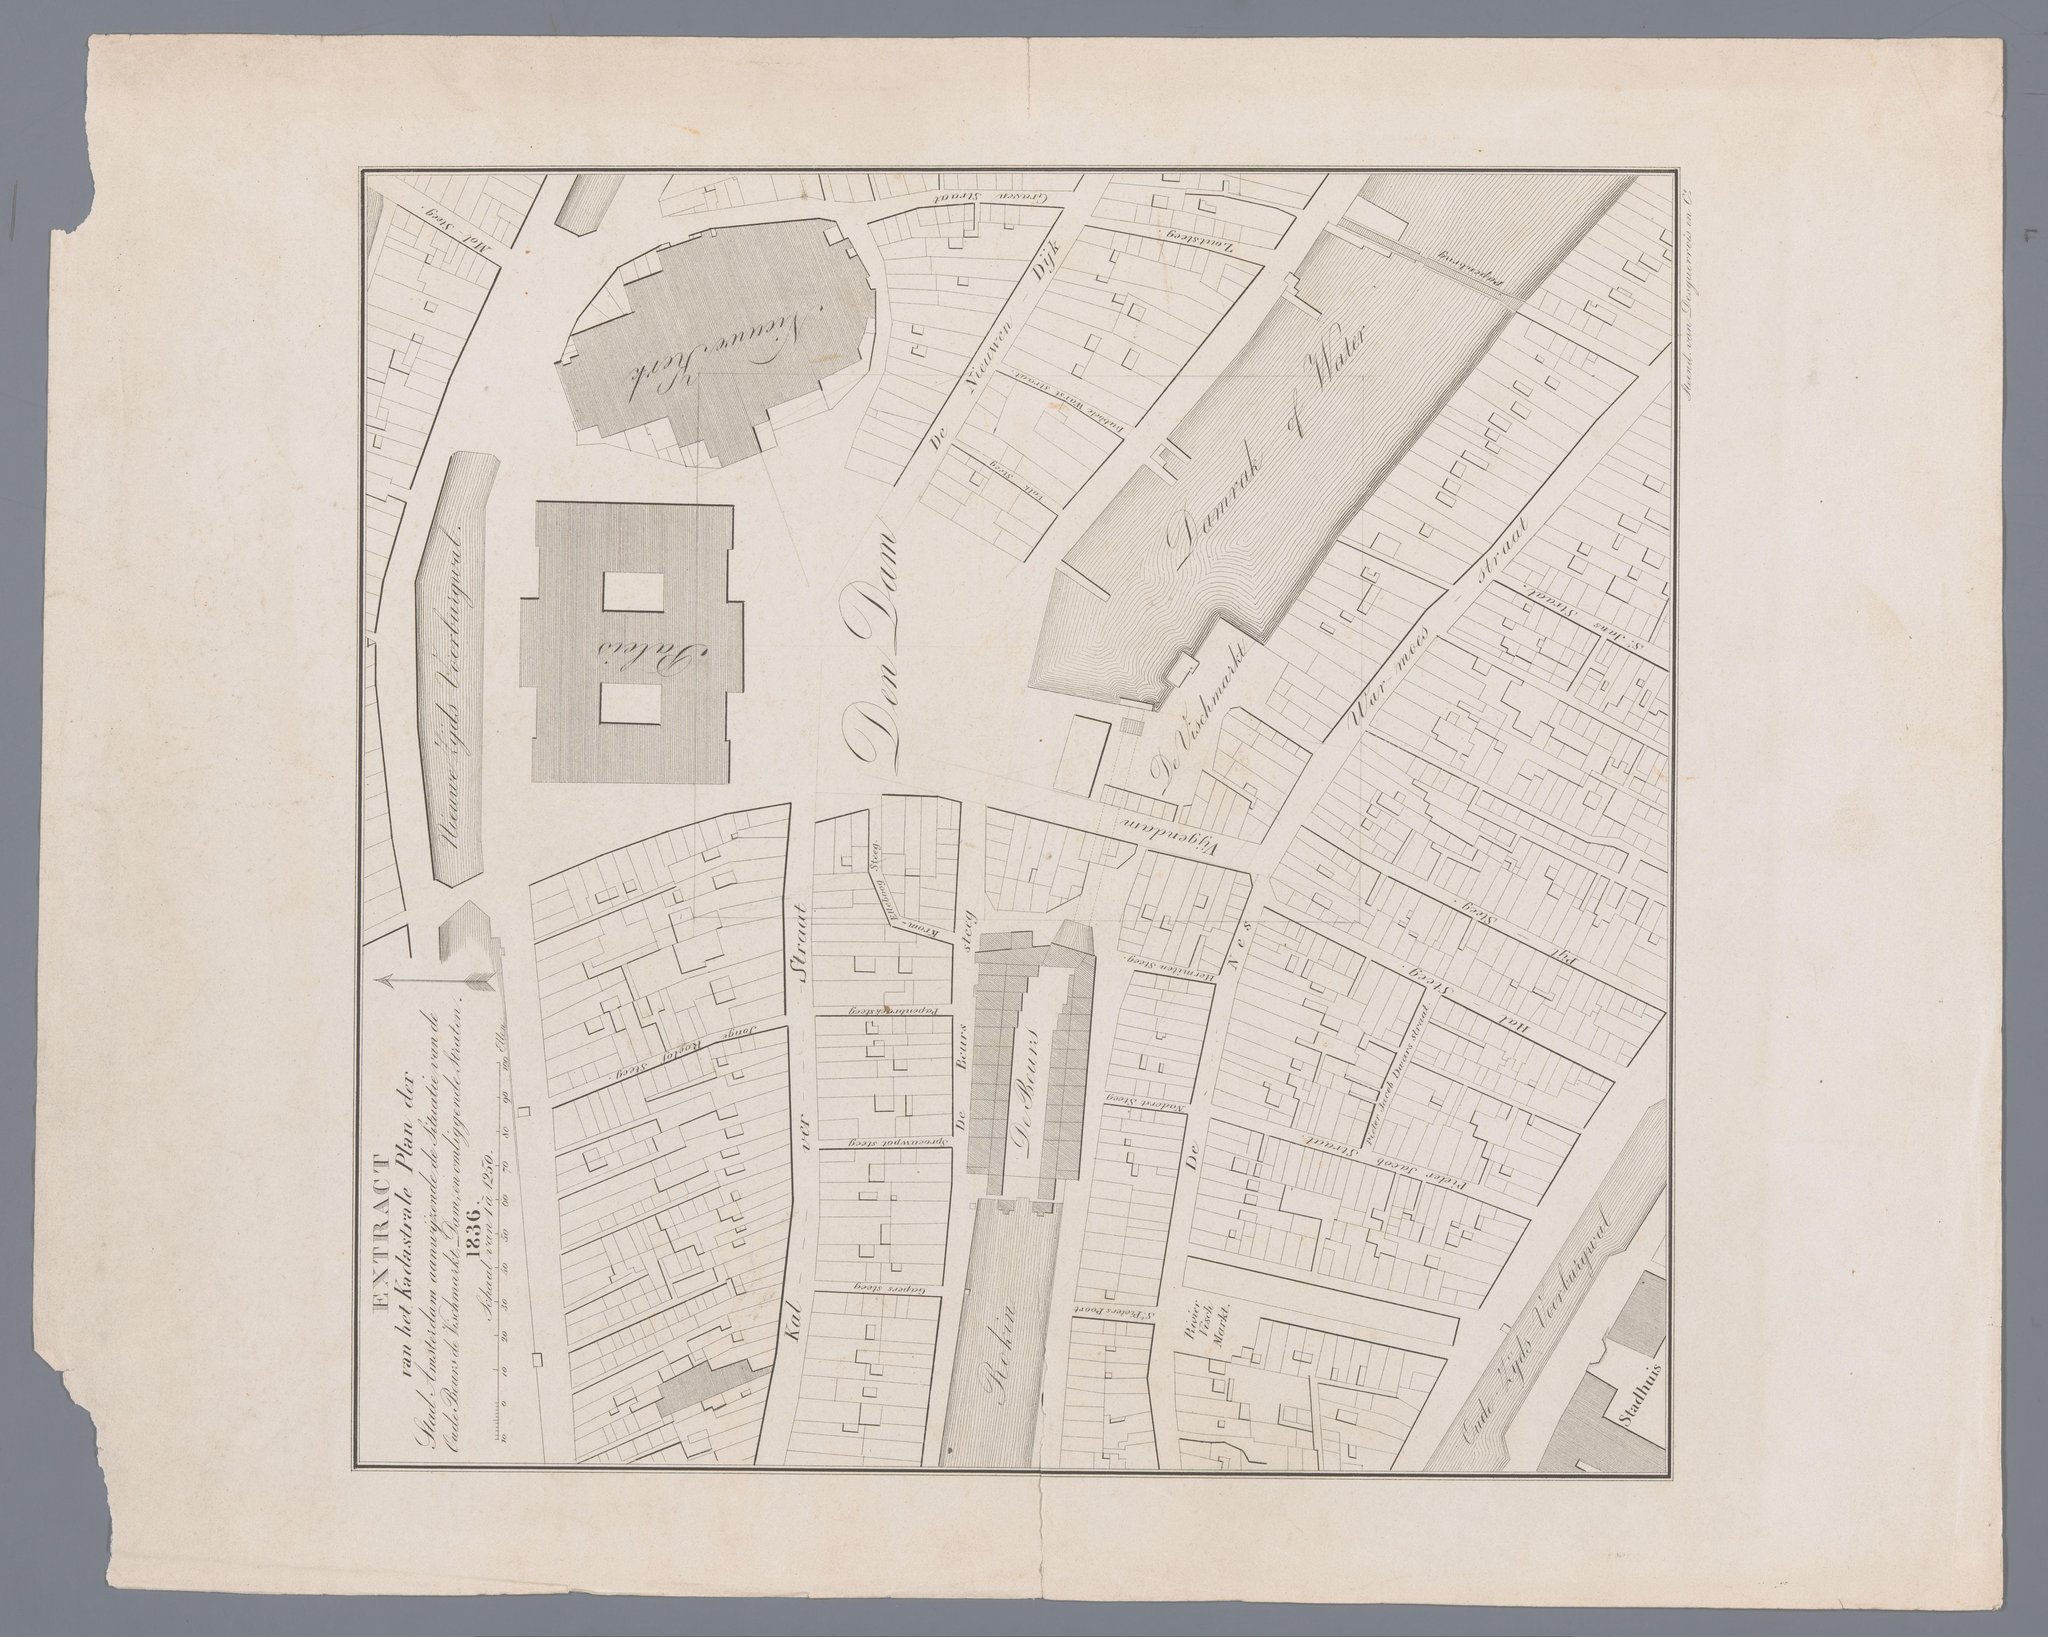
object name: print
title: Plattegrond van de Dam en omgeving, in Amsterdam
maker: Anonymous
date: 1836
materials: paper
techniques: lithograph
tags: maps of cities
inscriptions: collector's mark: Lugt 2228